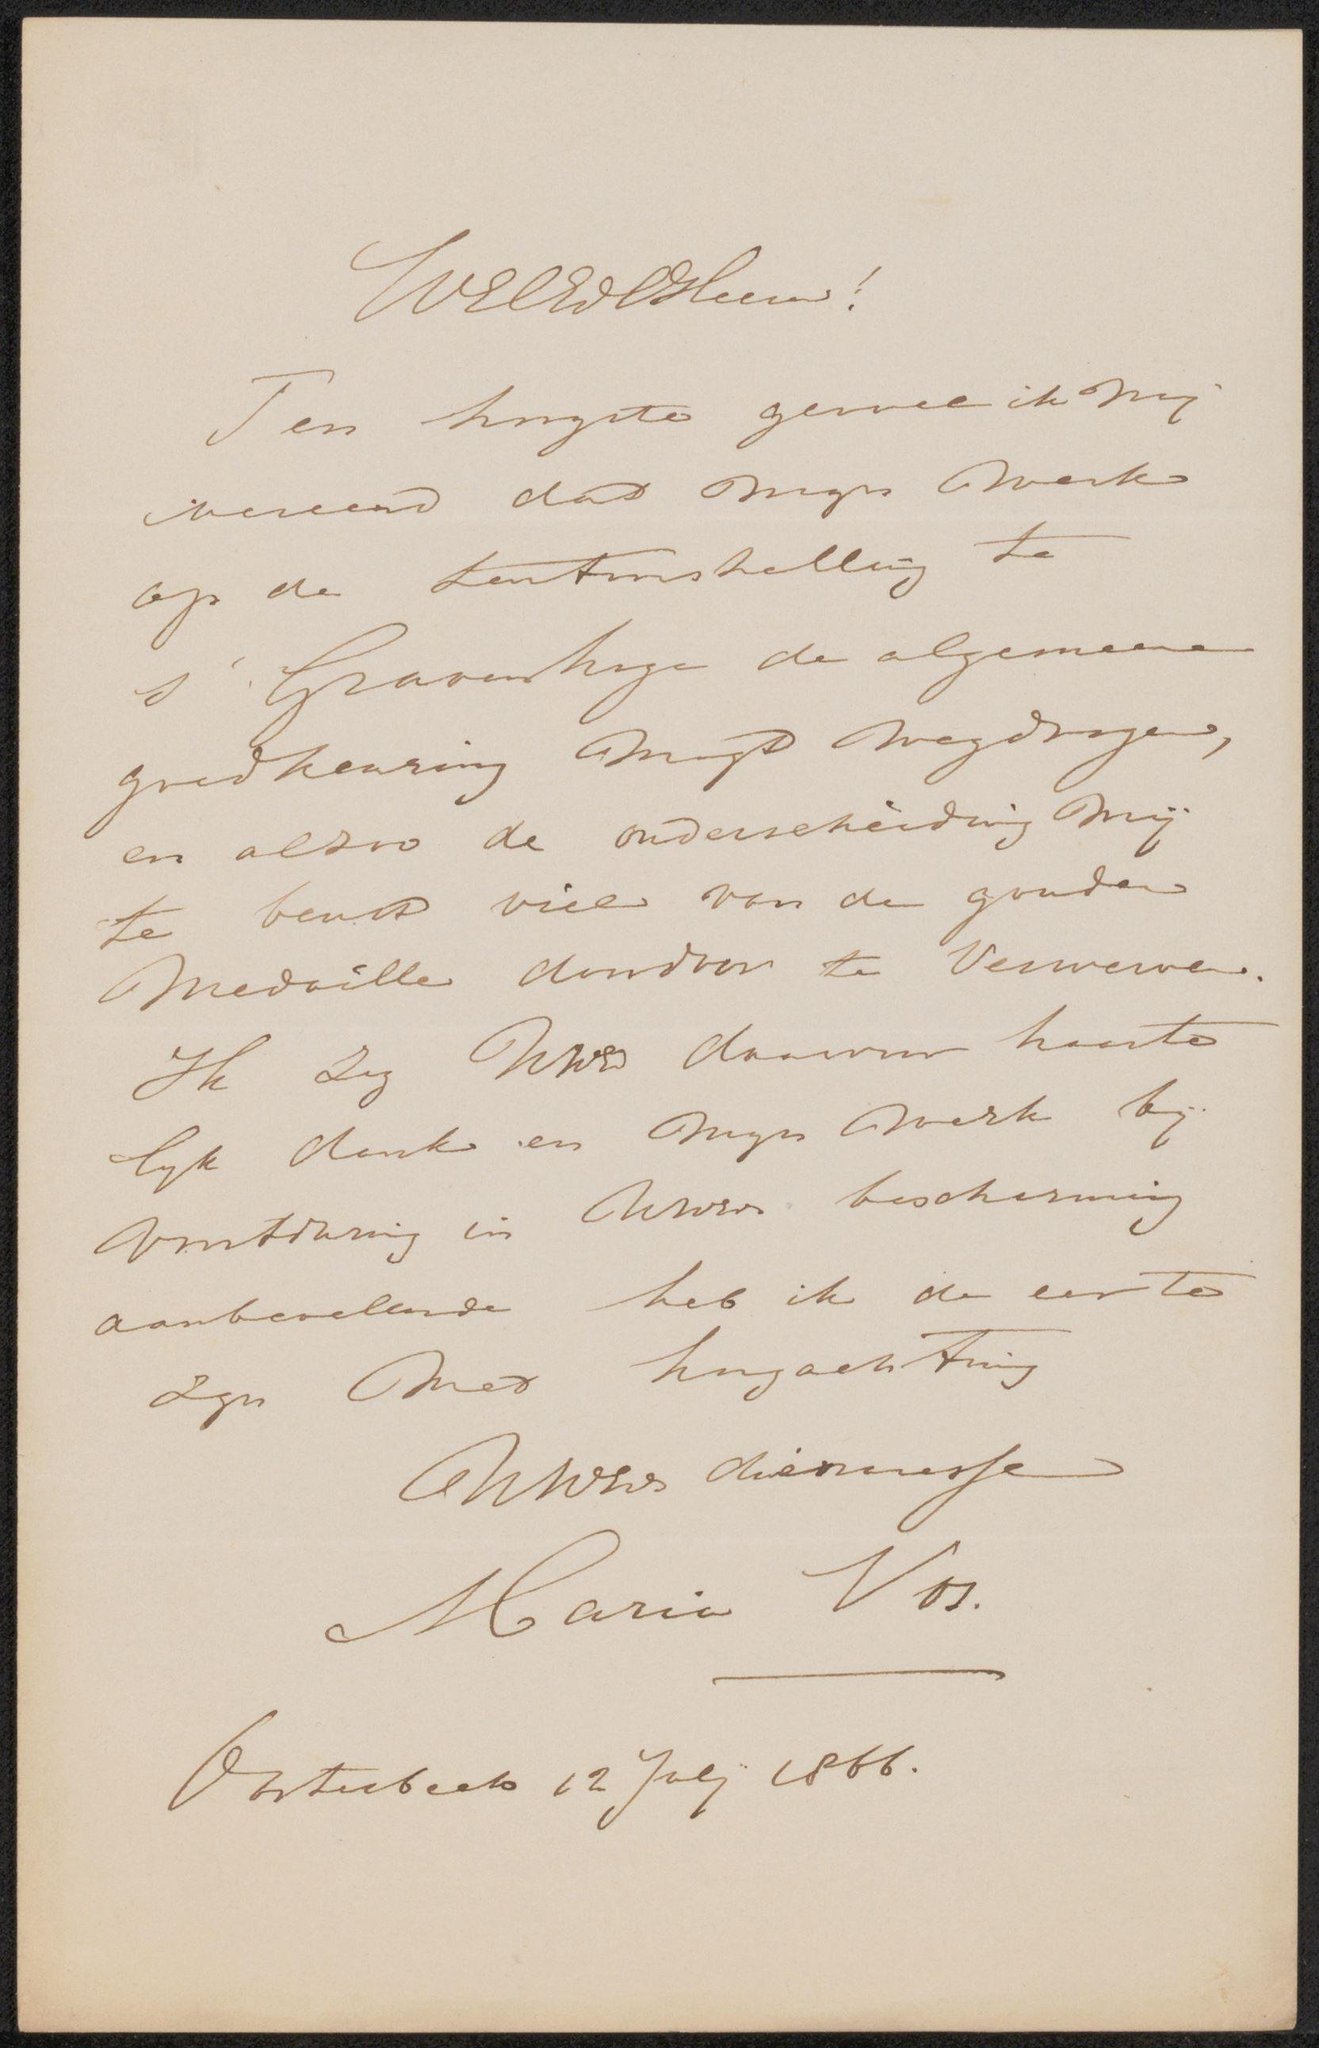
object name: letter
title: Brief aan de commissie van de Tentoonstelling van Levende Meesters in Den Haag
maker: maria vos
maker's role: draughtsman, painter, print maker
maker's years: 1824-1906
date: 1866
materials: ink, paper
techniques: pen, writing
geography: oosterbeek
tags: distribution of awards ~ art contest, exhibition ~ art, the hague